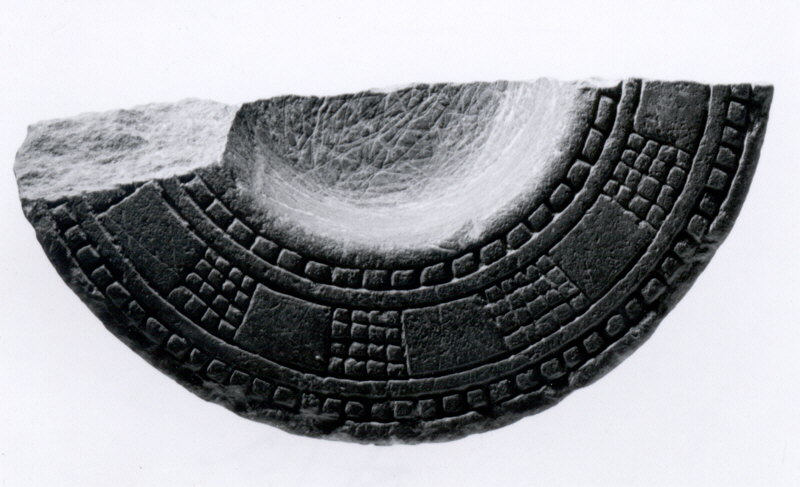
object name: cosmetic palette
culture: edomite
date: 700-601 BCE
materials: stone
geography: levant